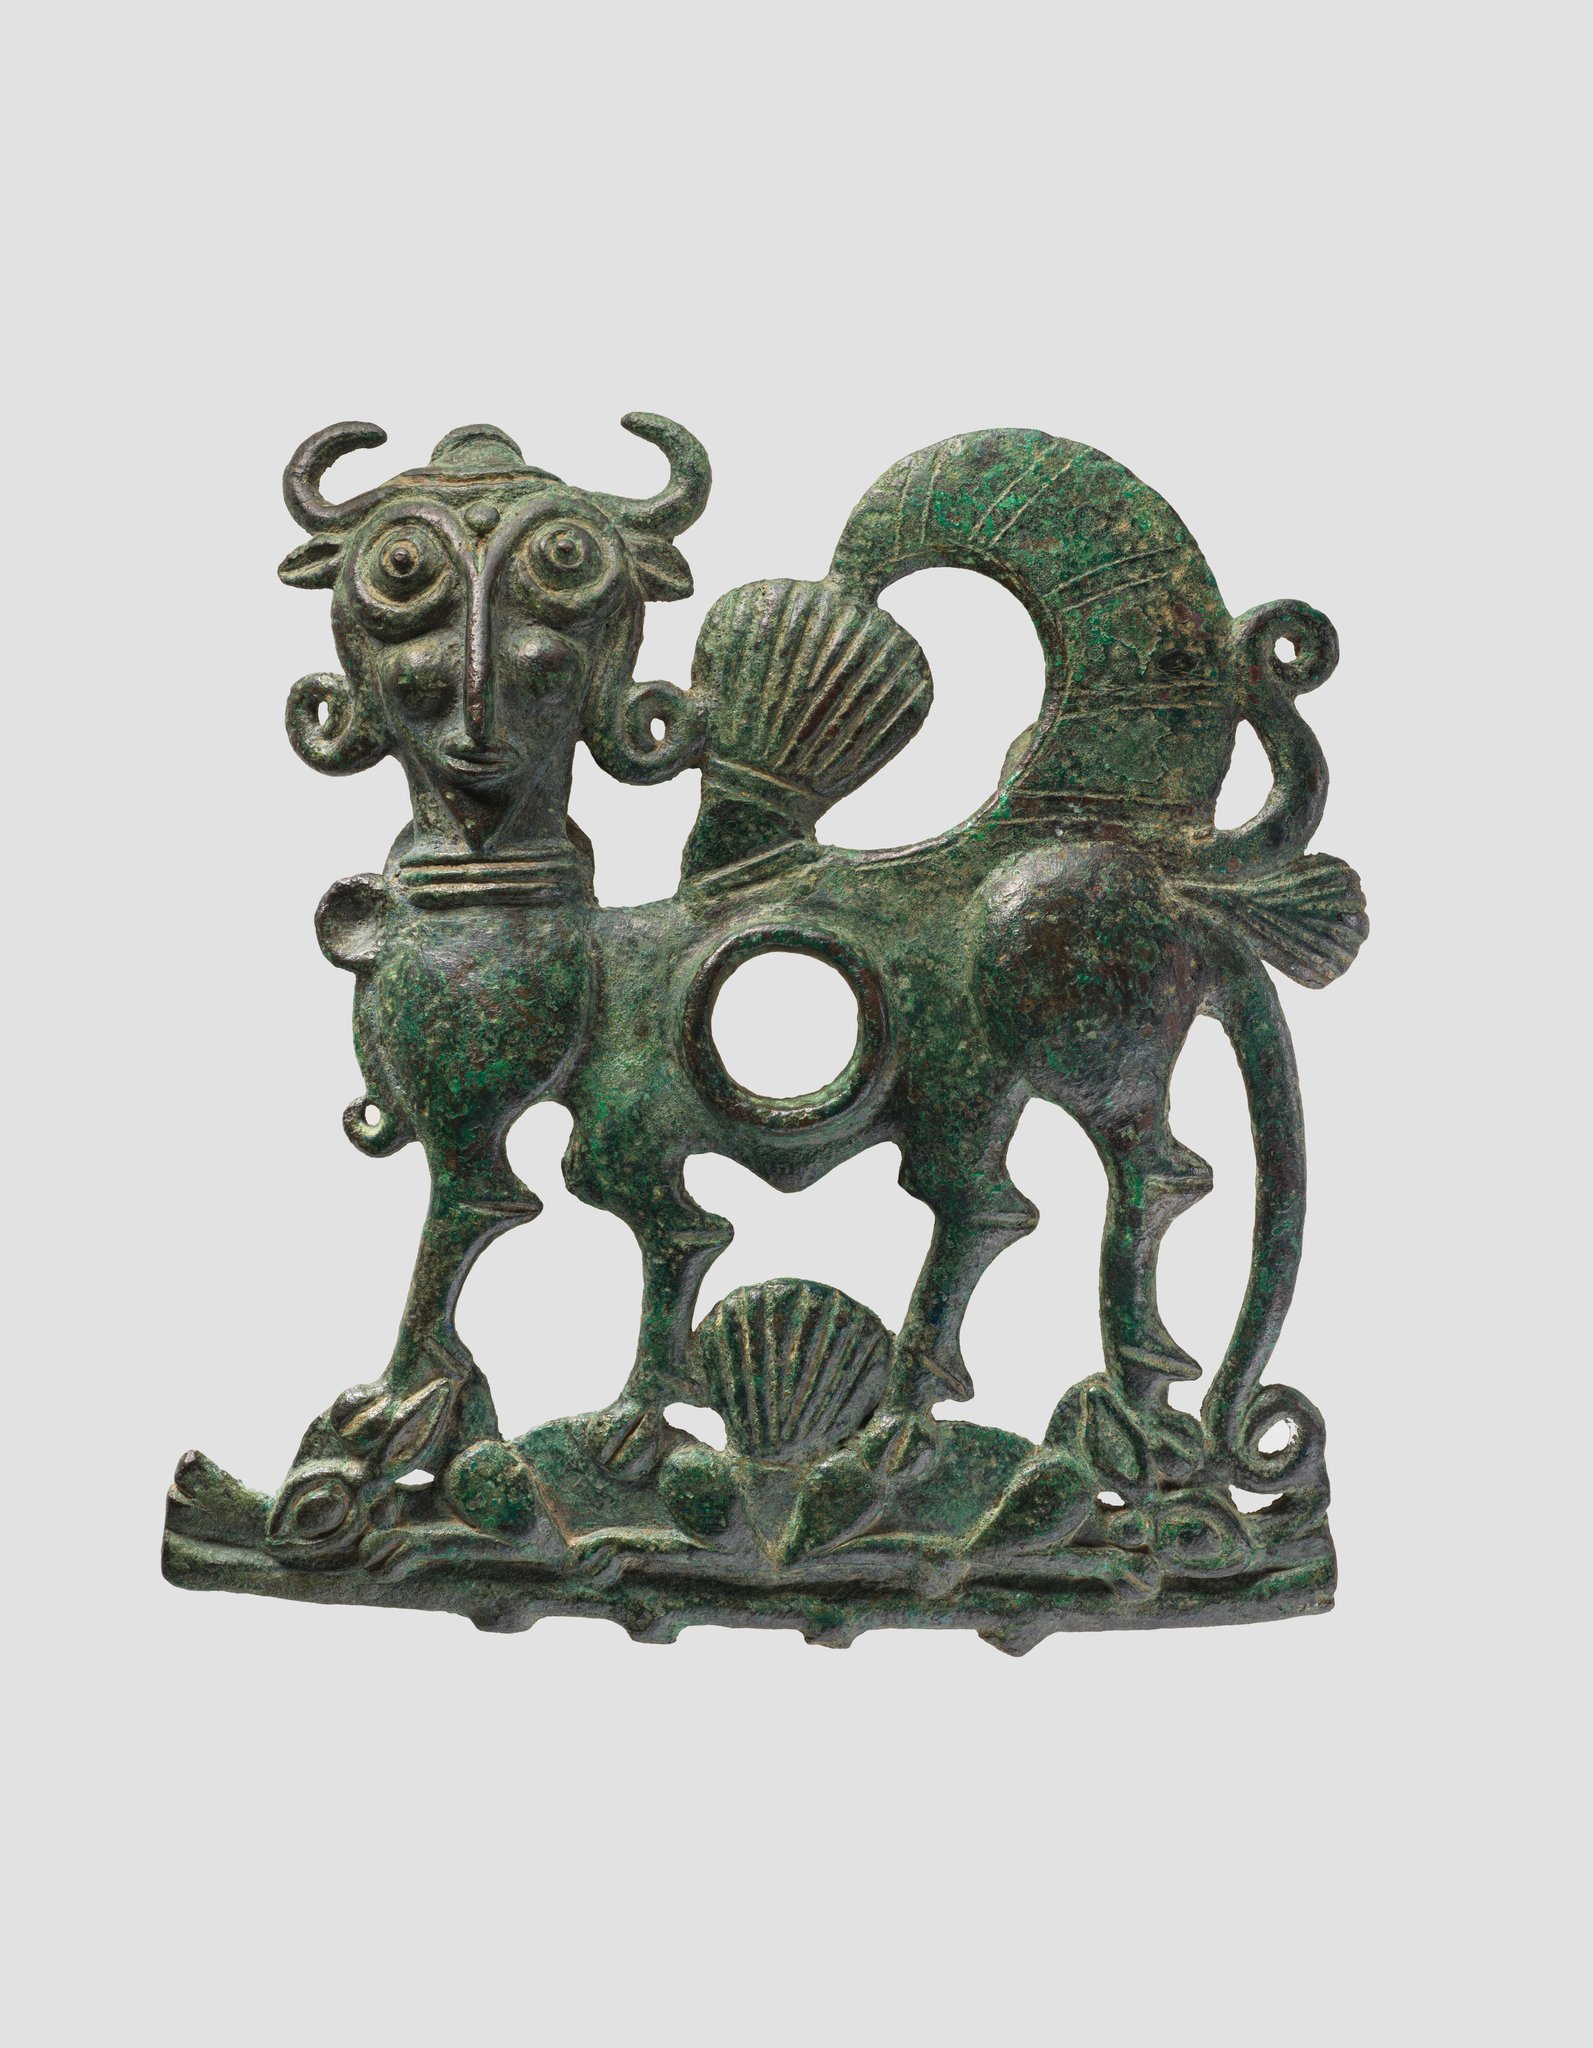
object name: horse bit cheekpiece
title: Horse bit cheekpiece in form of a winged, human-headed quadruped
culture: iranian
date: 800-701 BCE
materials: alloy, bronze, iron, lead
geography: iran, probably from luristan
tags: animals